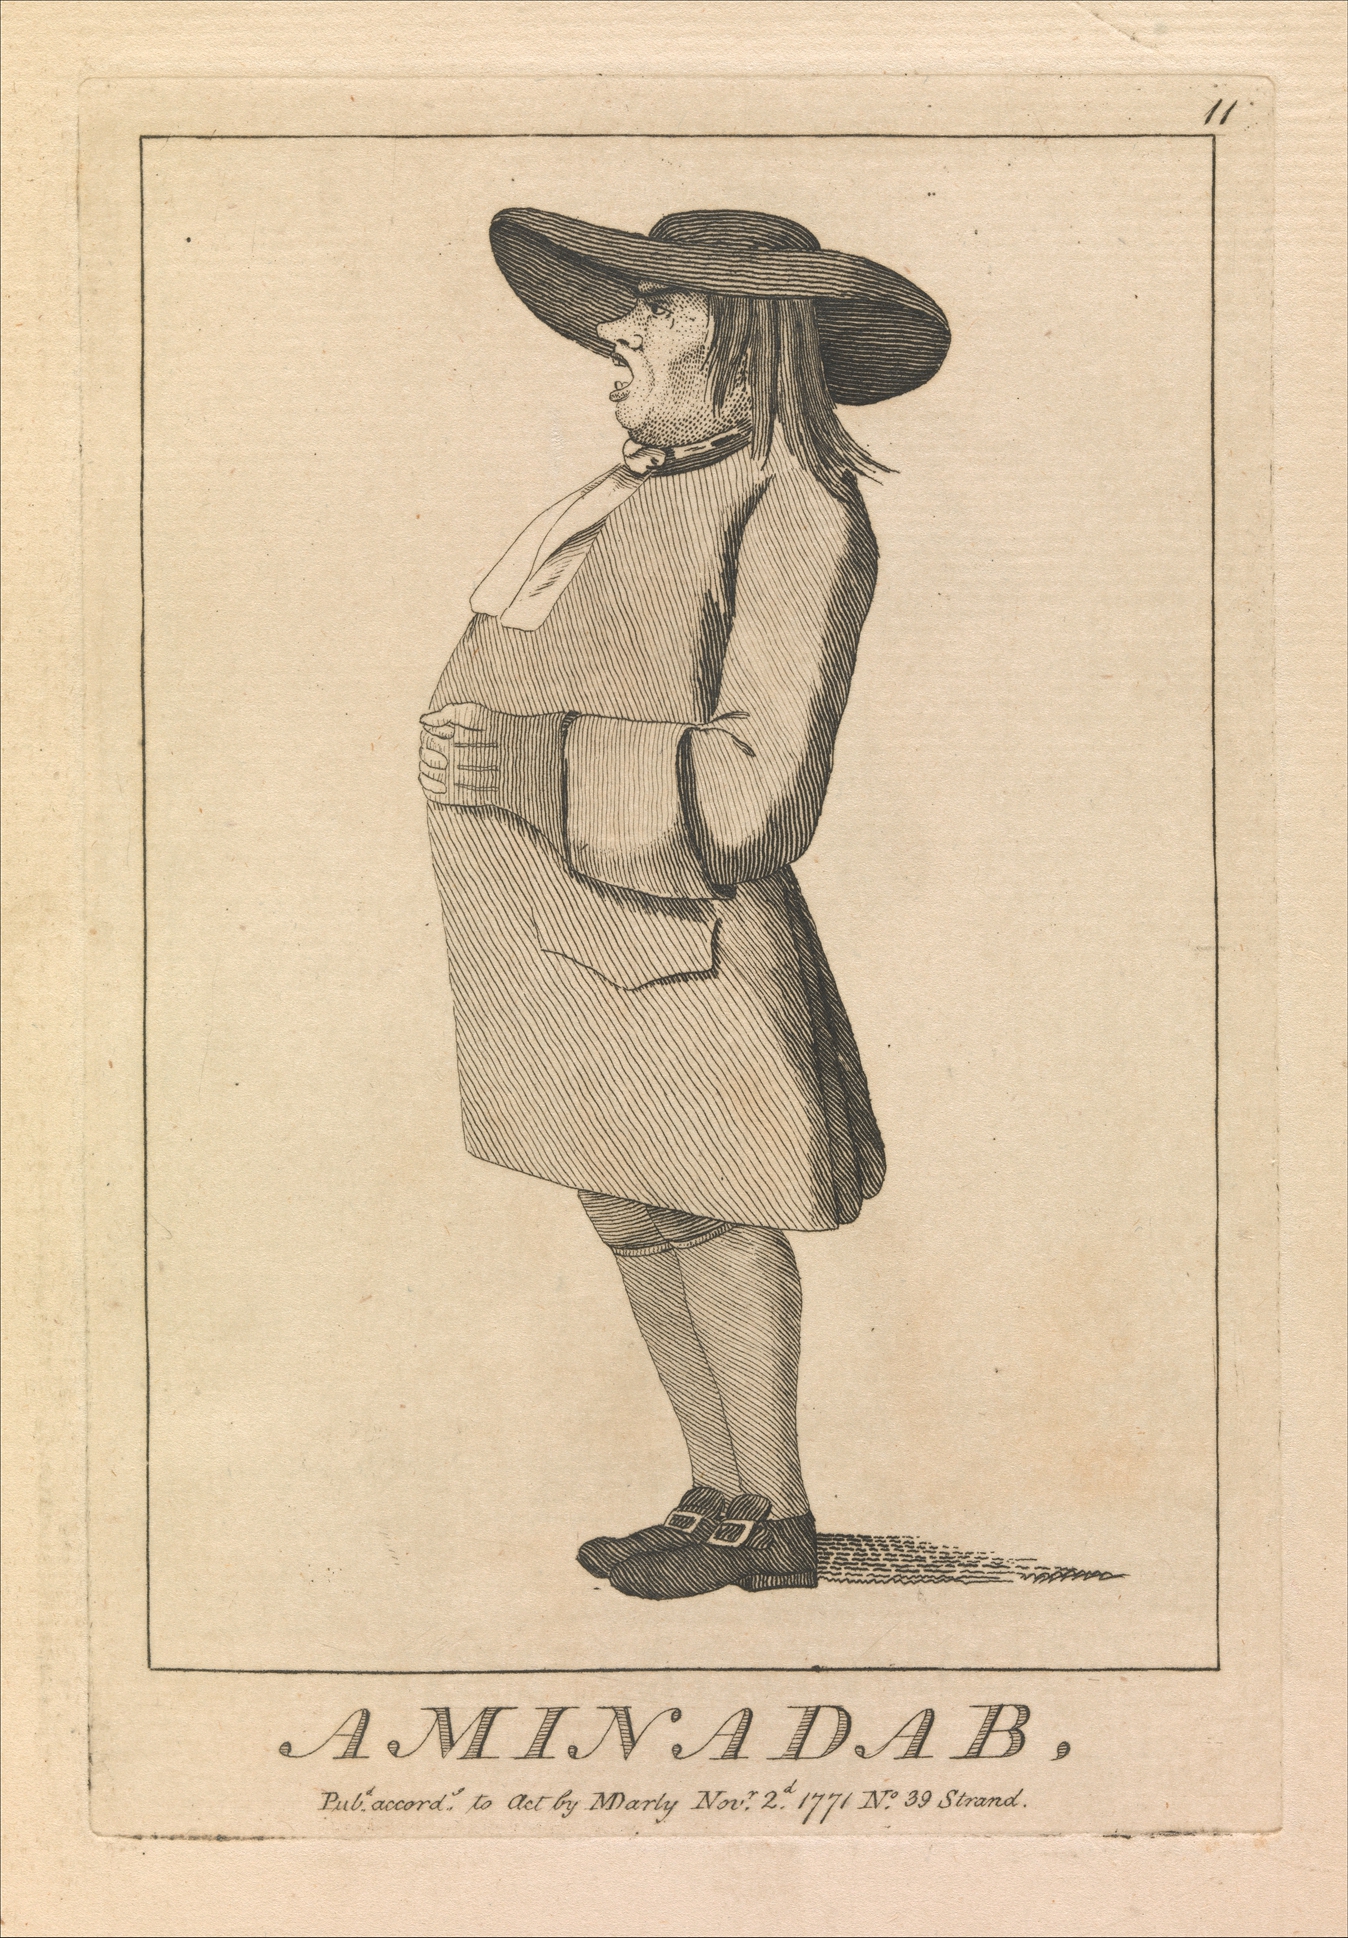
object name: print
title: Aminadab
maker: matthias darly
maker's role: publisher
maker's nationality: british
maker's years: 1720-1780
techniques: etching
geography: london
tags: women